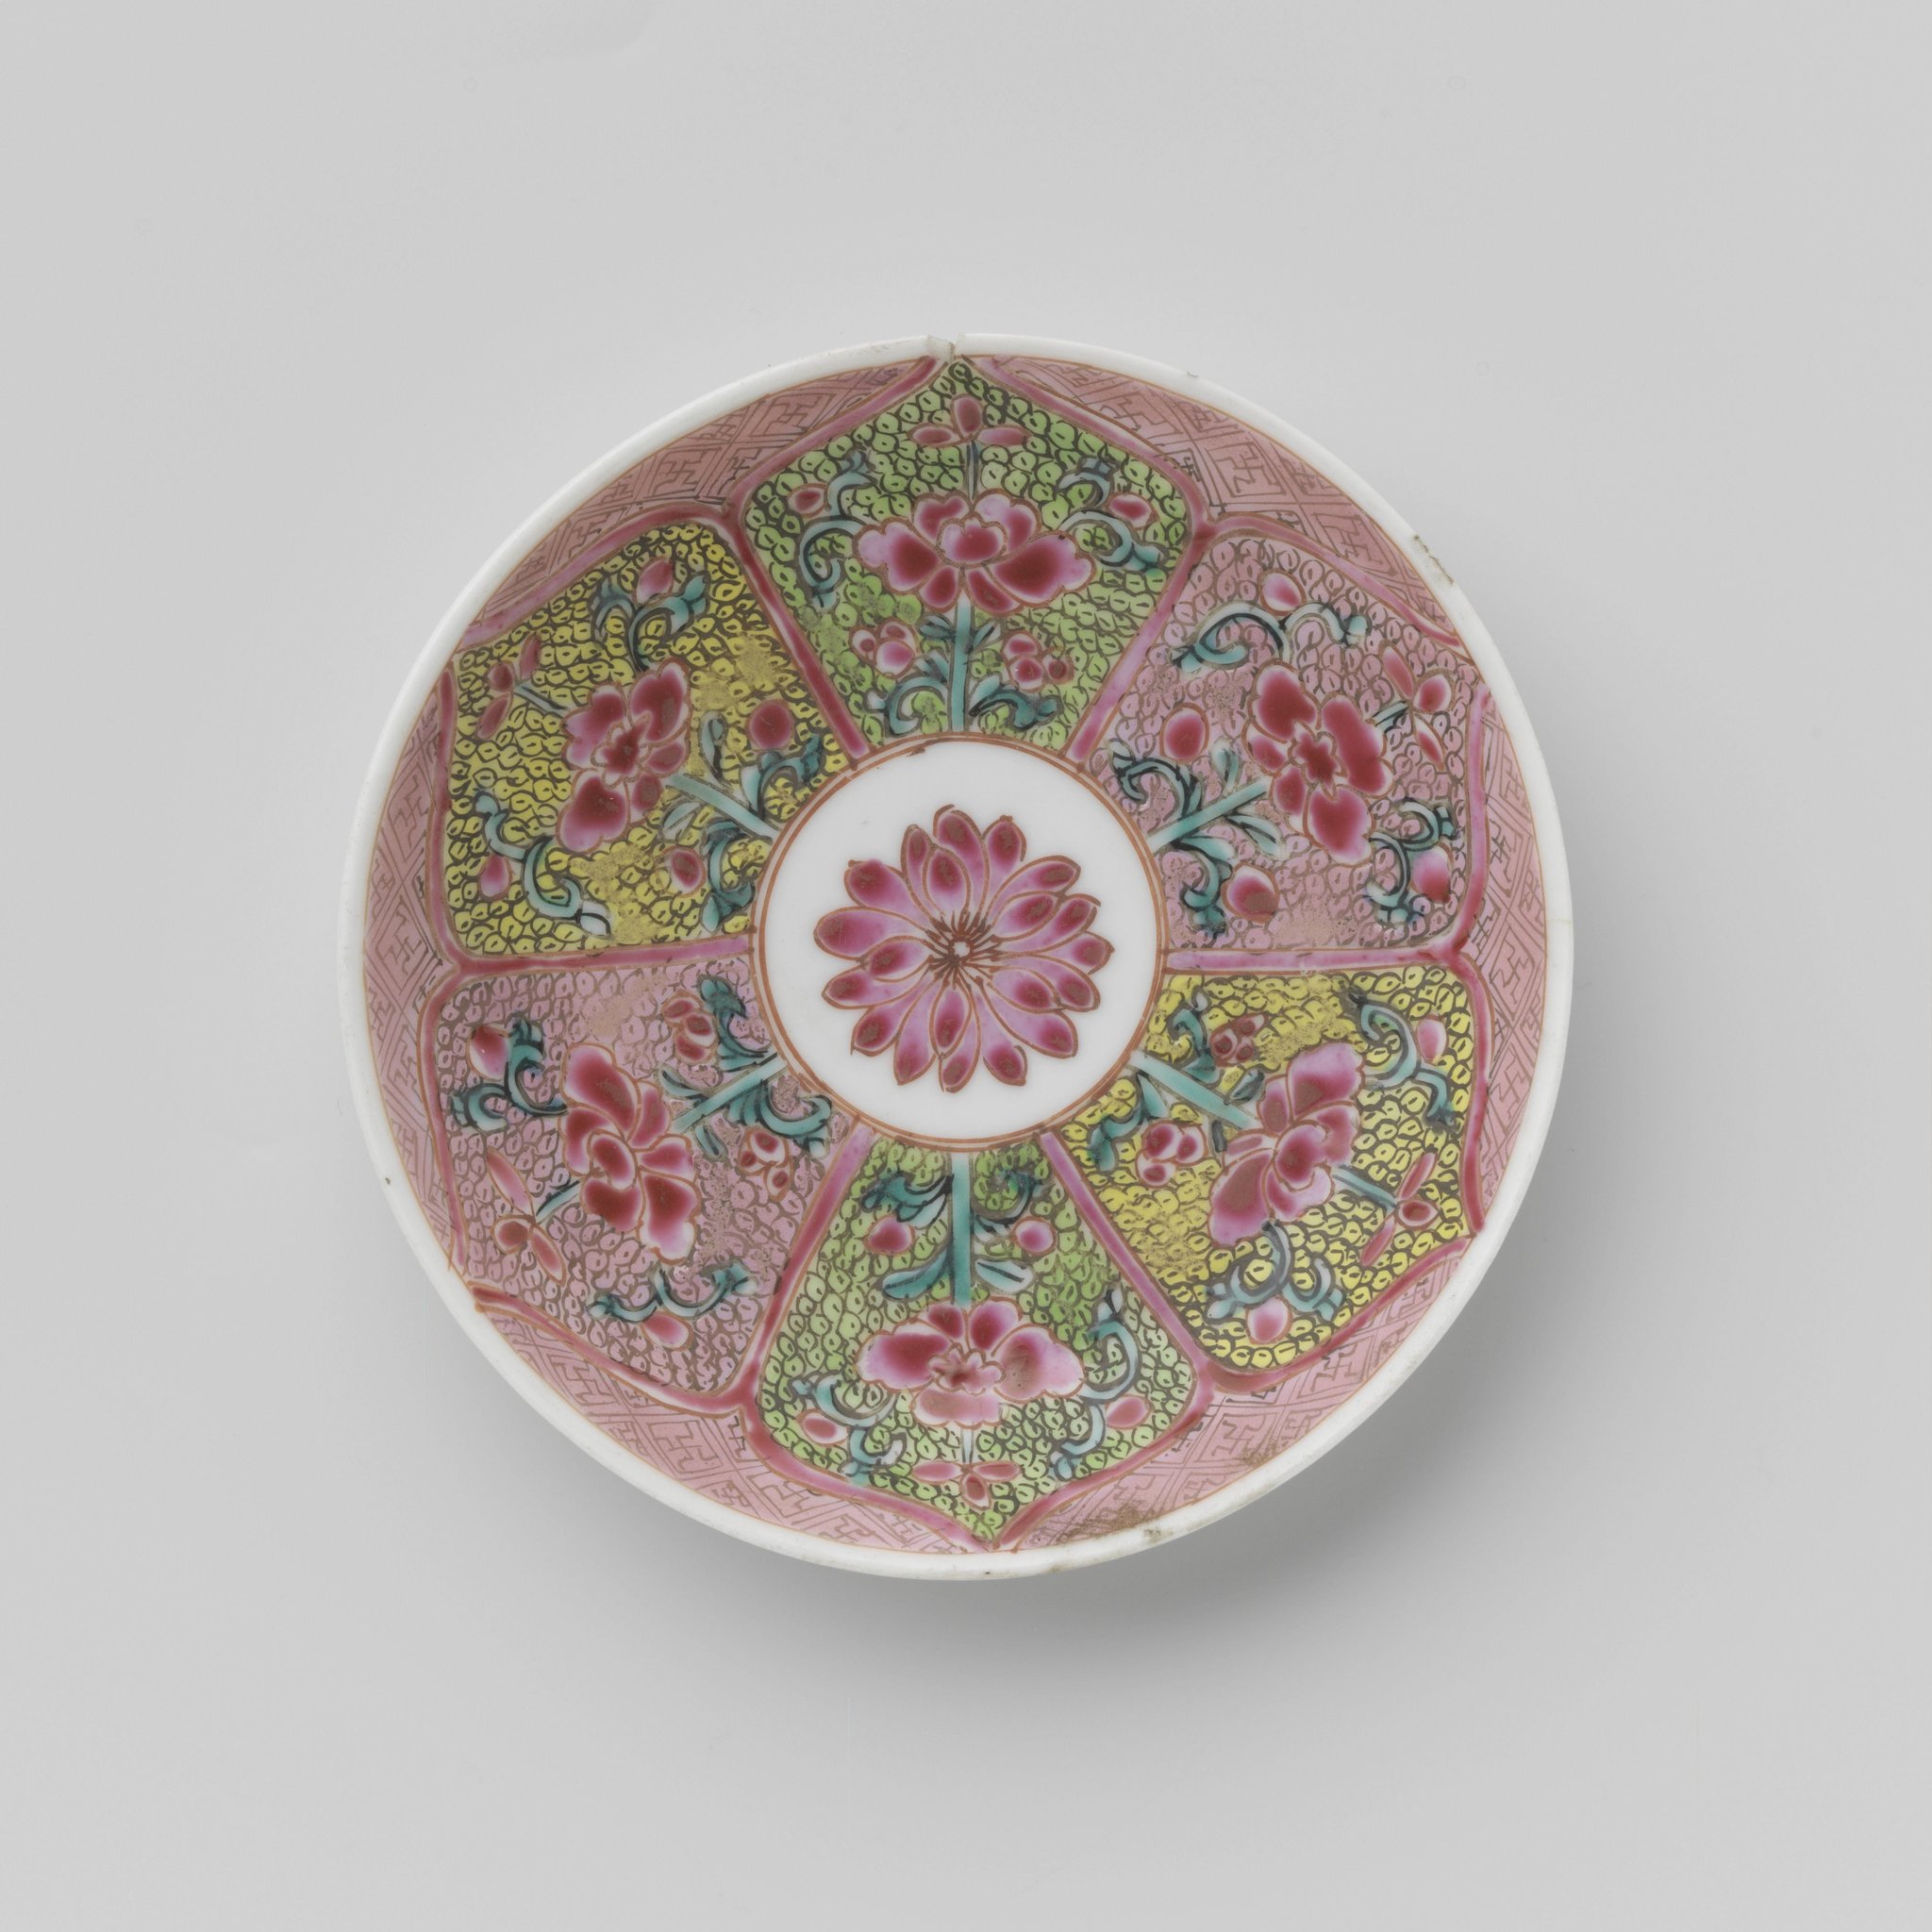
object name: kop en schotel, kop en schotel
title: Saucer with floral scrolls in petal-shaped panels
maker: Anonymous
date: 1725-1749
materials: glaze, paint, porcelain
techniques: firing, turning, vitrification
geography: china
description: Schotel van porselein met rechte, uitlopende wand, beschilderd op het glazuur in blauw, rood, groen, geel en zwart. Op het plat van de schotel vakken in de vorm van een bloem, in het centrum een lotus en in de bloembladvormige vakken bloemranken op verschillend gekleurd servetwerk; op de rand een swastika-patroon. Een barst in de wand. Famille rose.